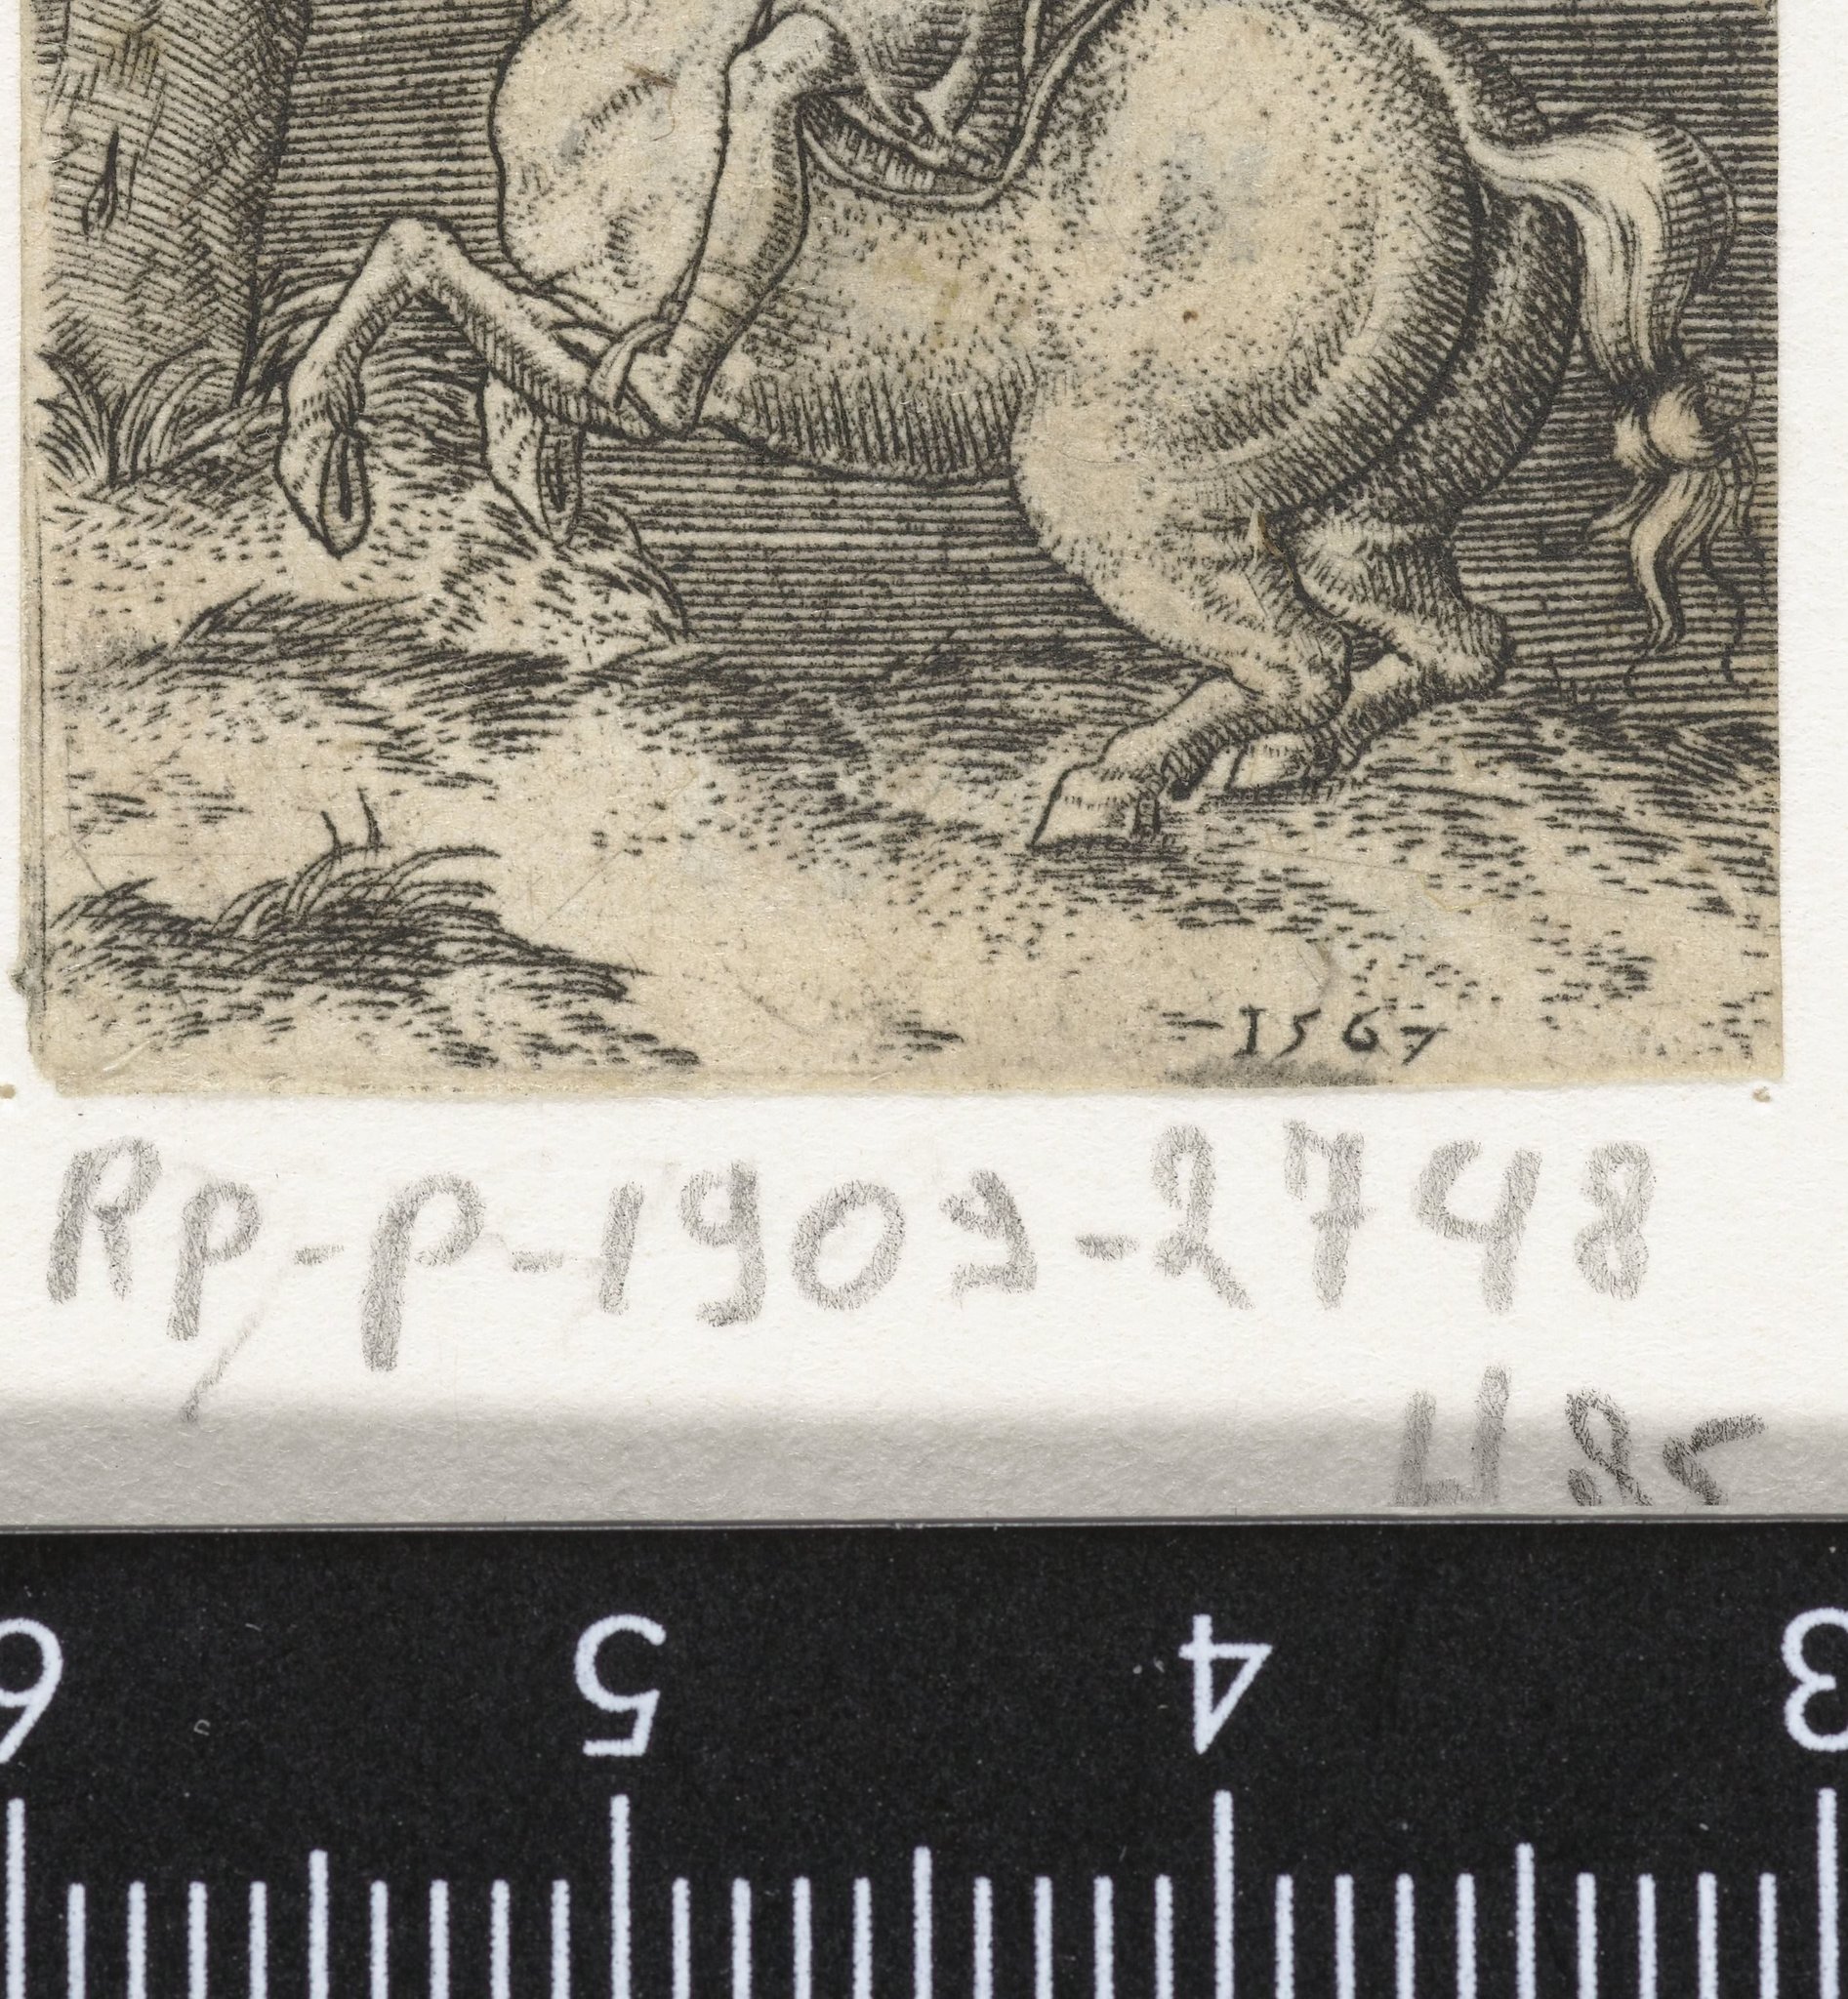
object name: print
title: Romeinse ruiter te paard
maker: abraham de bruyn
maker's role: print maker, publisher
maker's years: 1540-1587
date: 1567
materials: paper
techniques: engraving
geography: antwerp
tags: warfare; military affairs (+ cavalry, horsemen)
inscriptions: collector's mark: Lugt 2228, collector's mark: Lugt 2773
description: Een Romeins soldaat te paard, rijdend naar links. Het paard steigert.